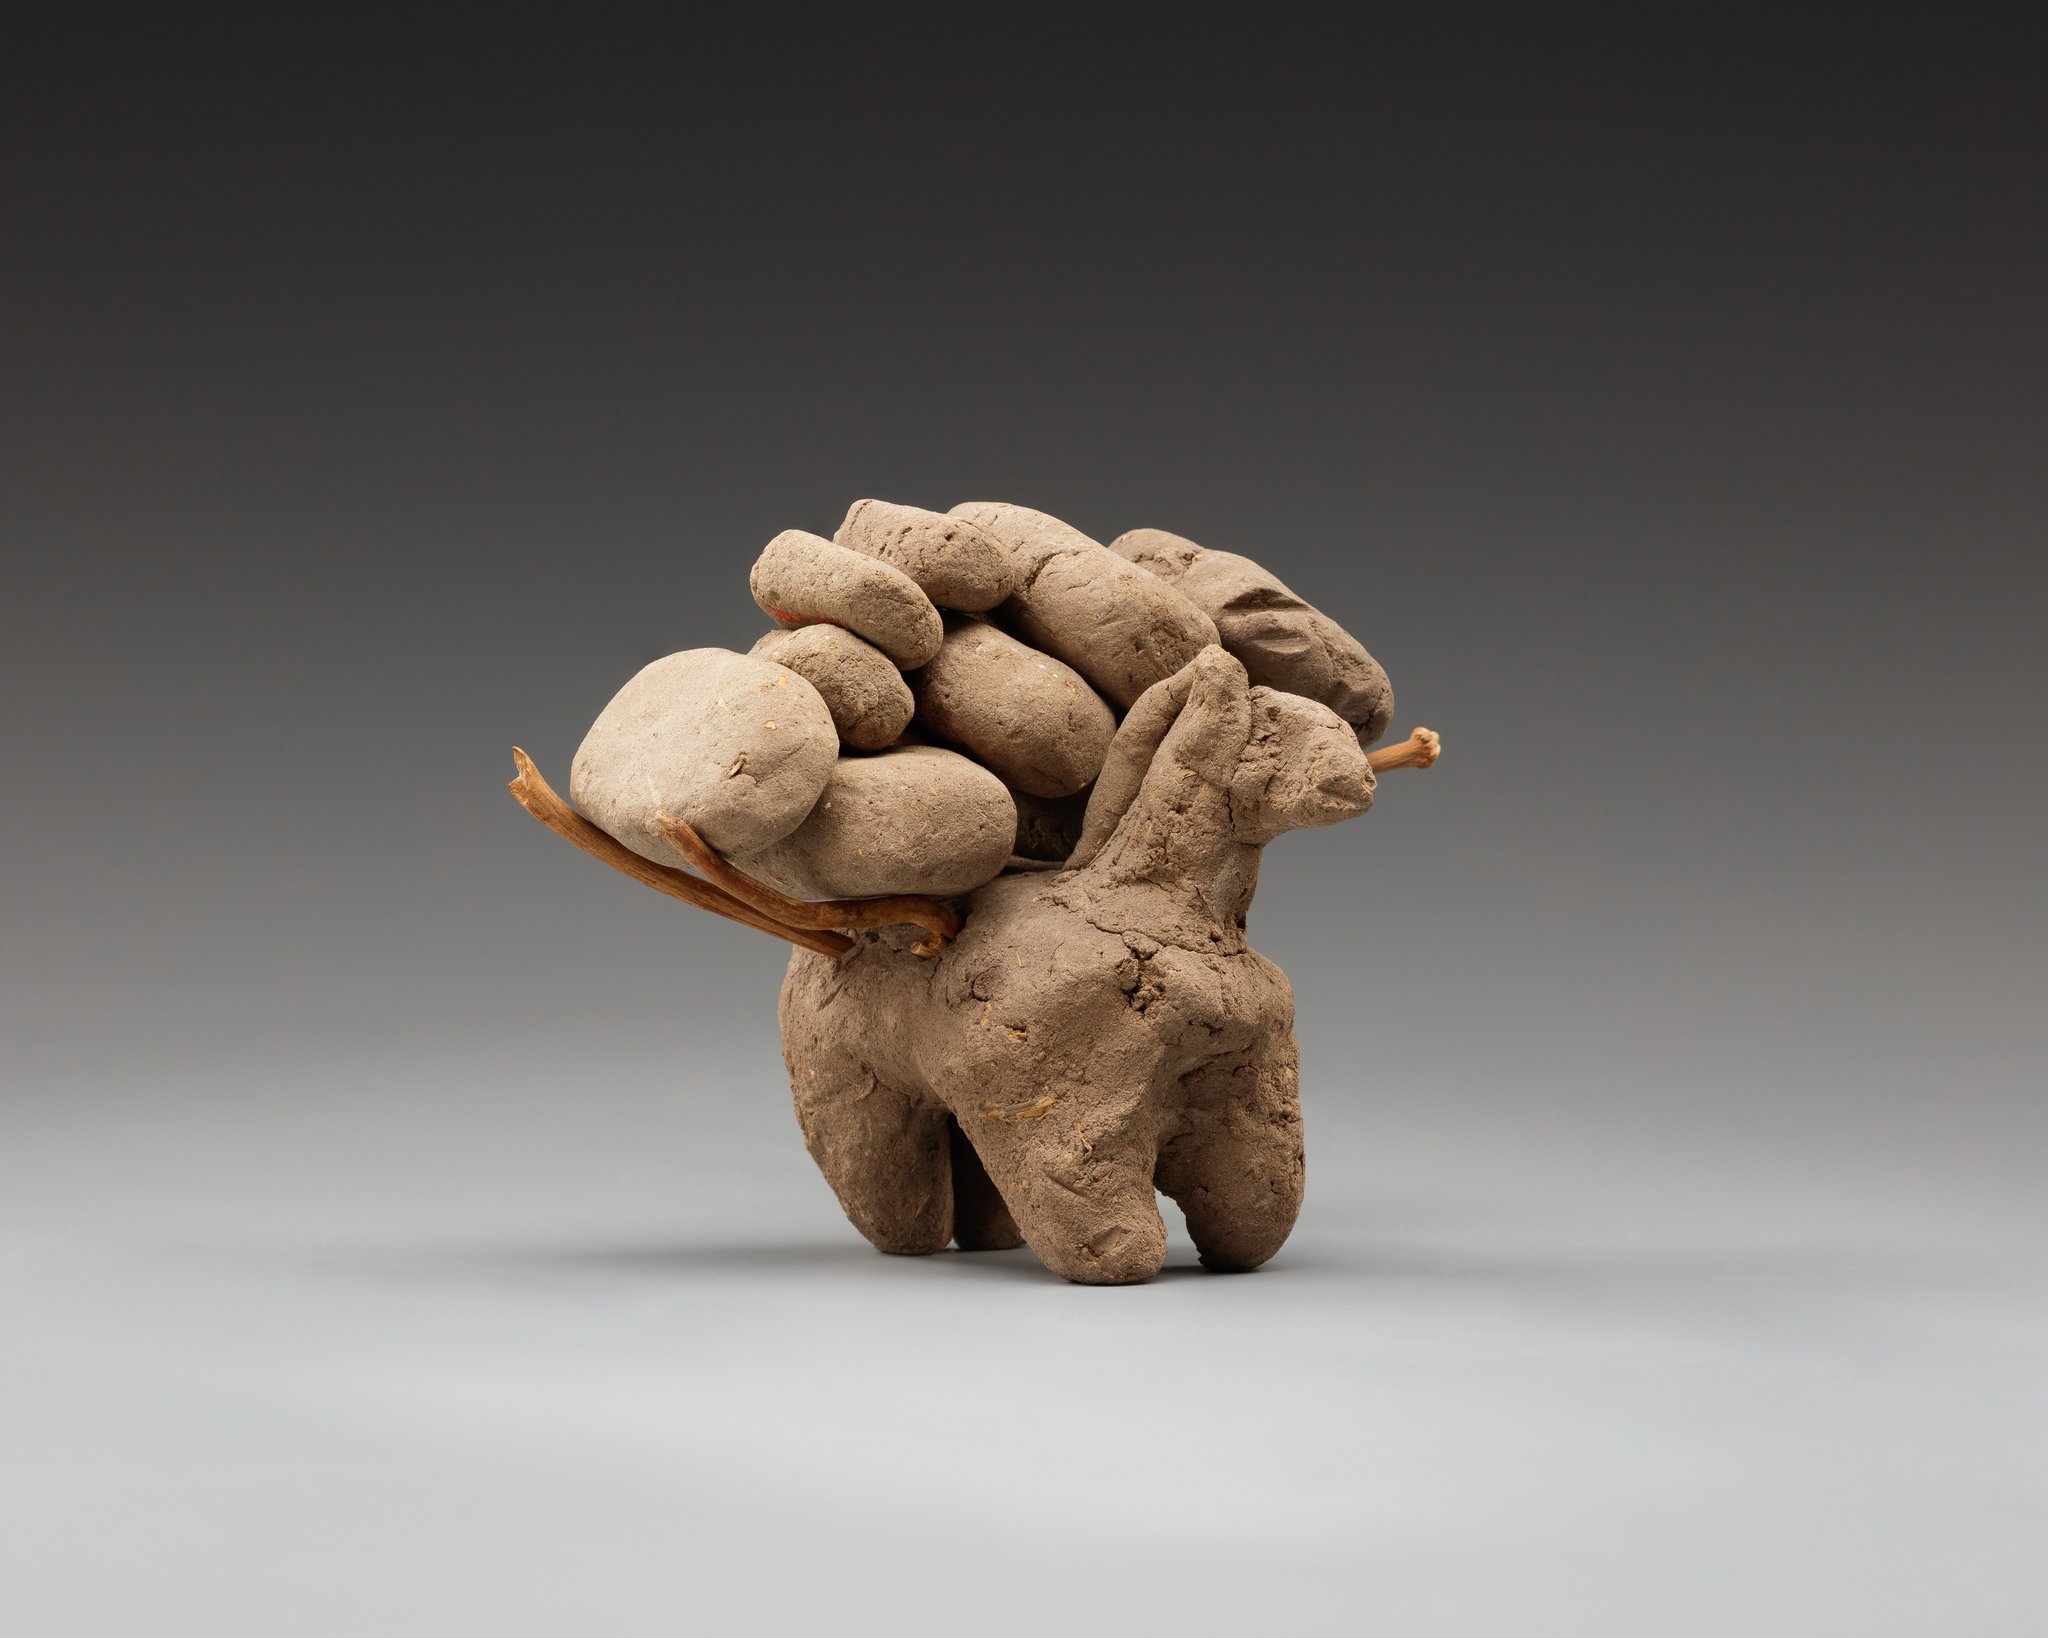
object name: figurine, donkey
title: Donkey with packs on its back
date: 1991-1450 BCE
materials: clay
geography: egypt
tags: donkeys